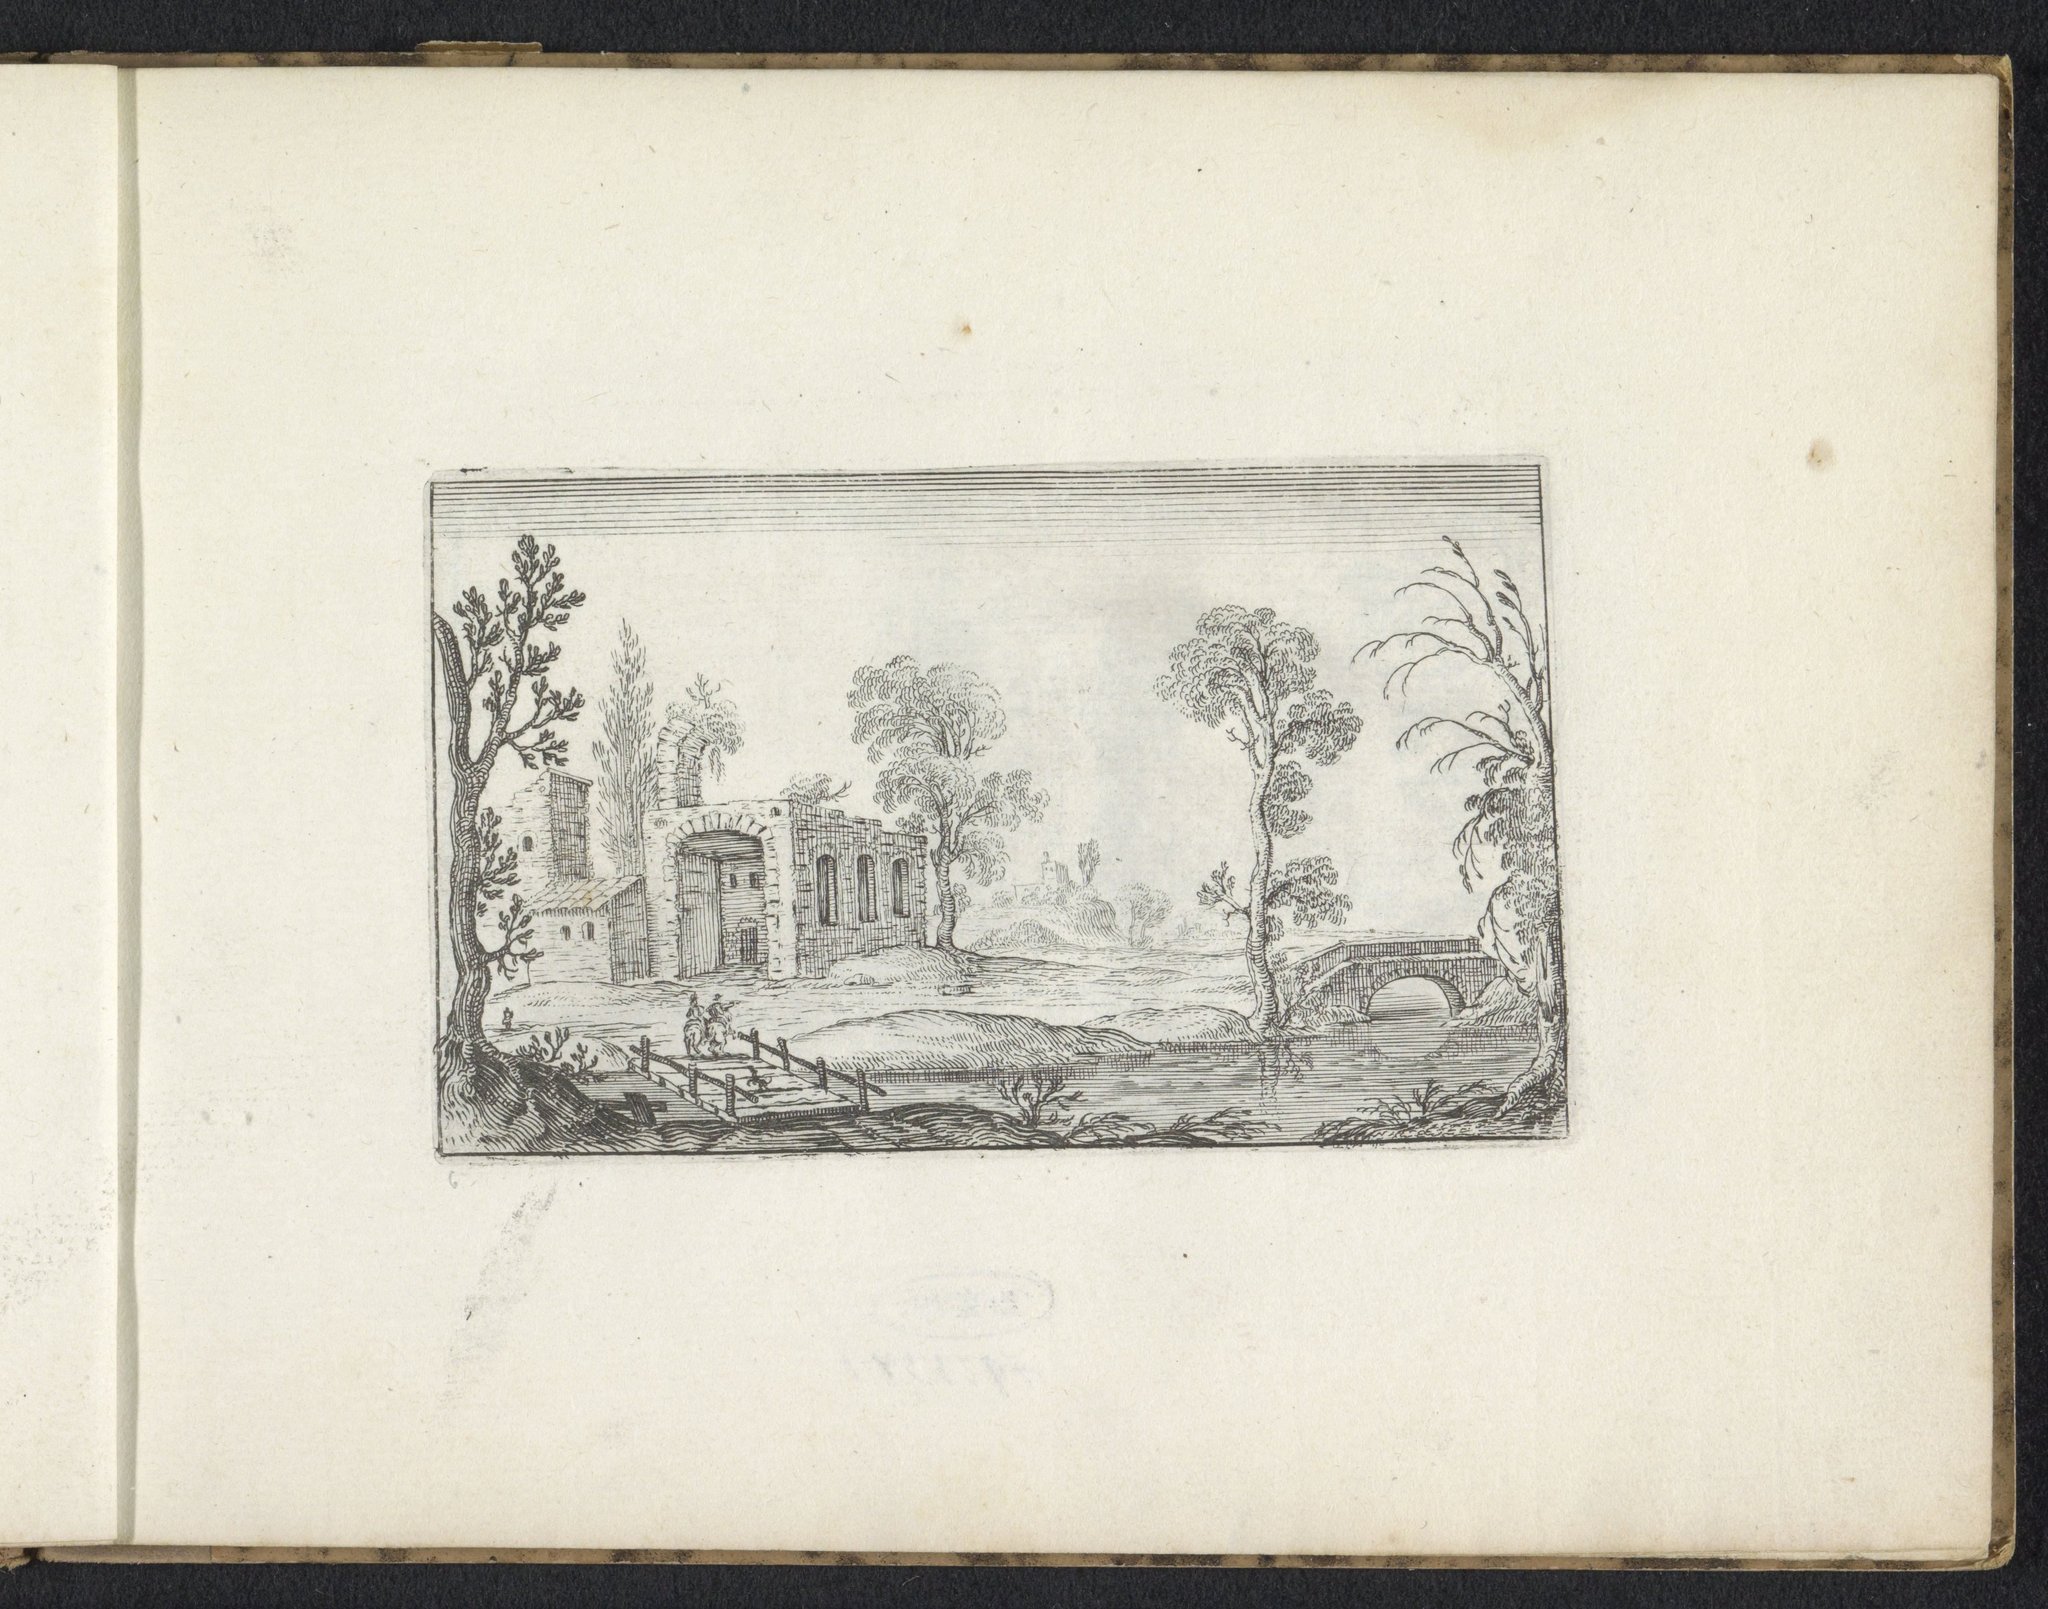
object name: album leaf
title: Zeven landschappen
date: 1610-1638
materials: paper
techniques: etching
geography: northern netherlands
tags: city-view, and landscape with man-made constructions, landscapes, bridge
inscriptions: collector's mark: Lugt 2228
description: Landschap met links een huis en daarbij een houten en een stenen brug over een rivier. Over de houten brug twee mannen te paard en een hond. De prent maakt deel uit van een album.